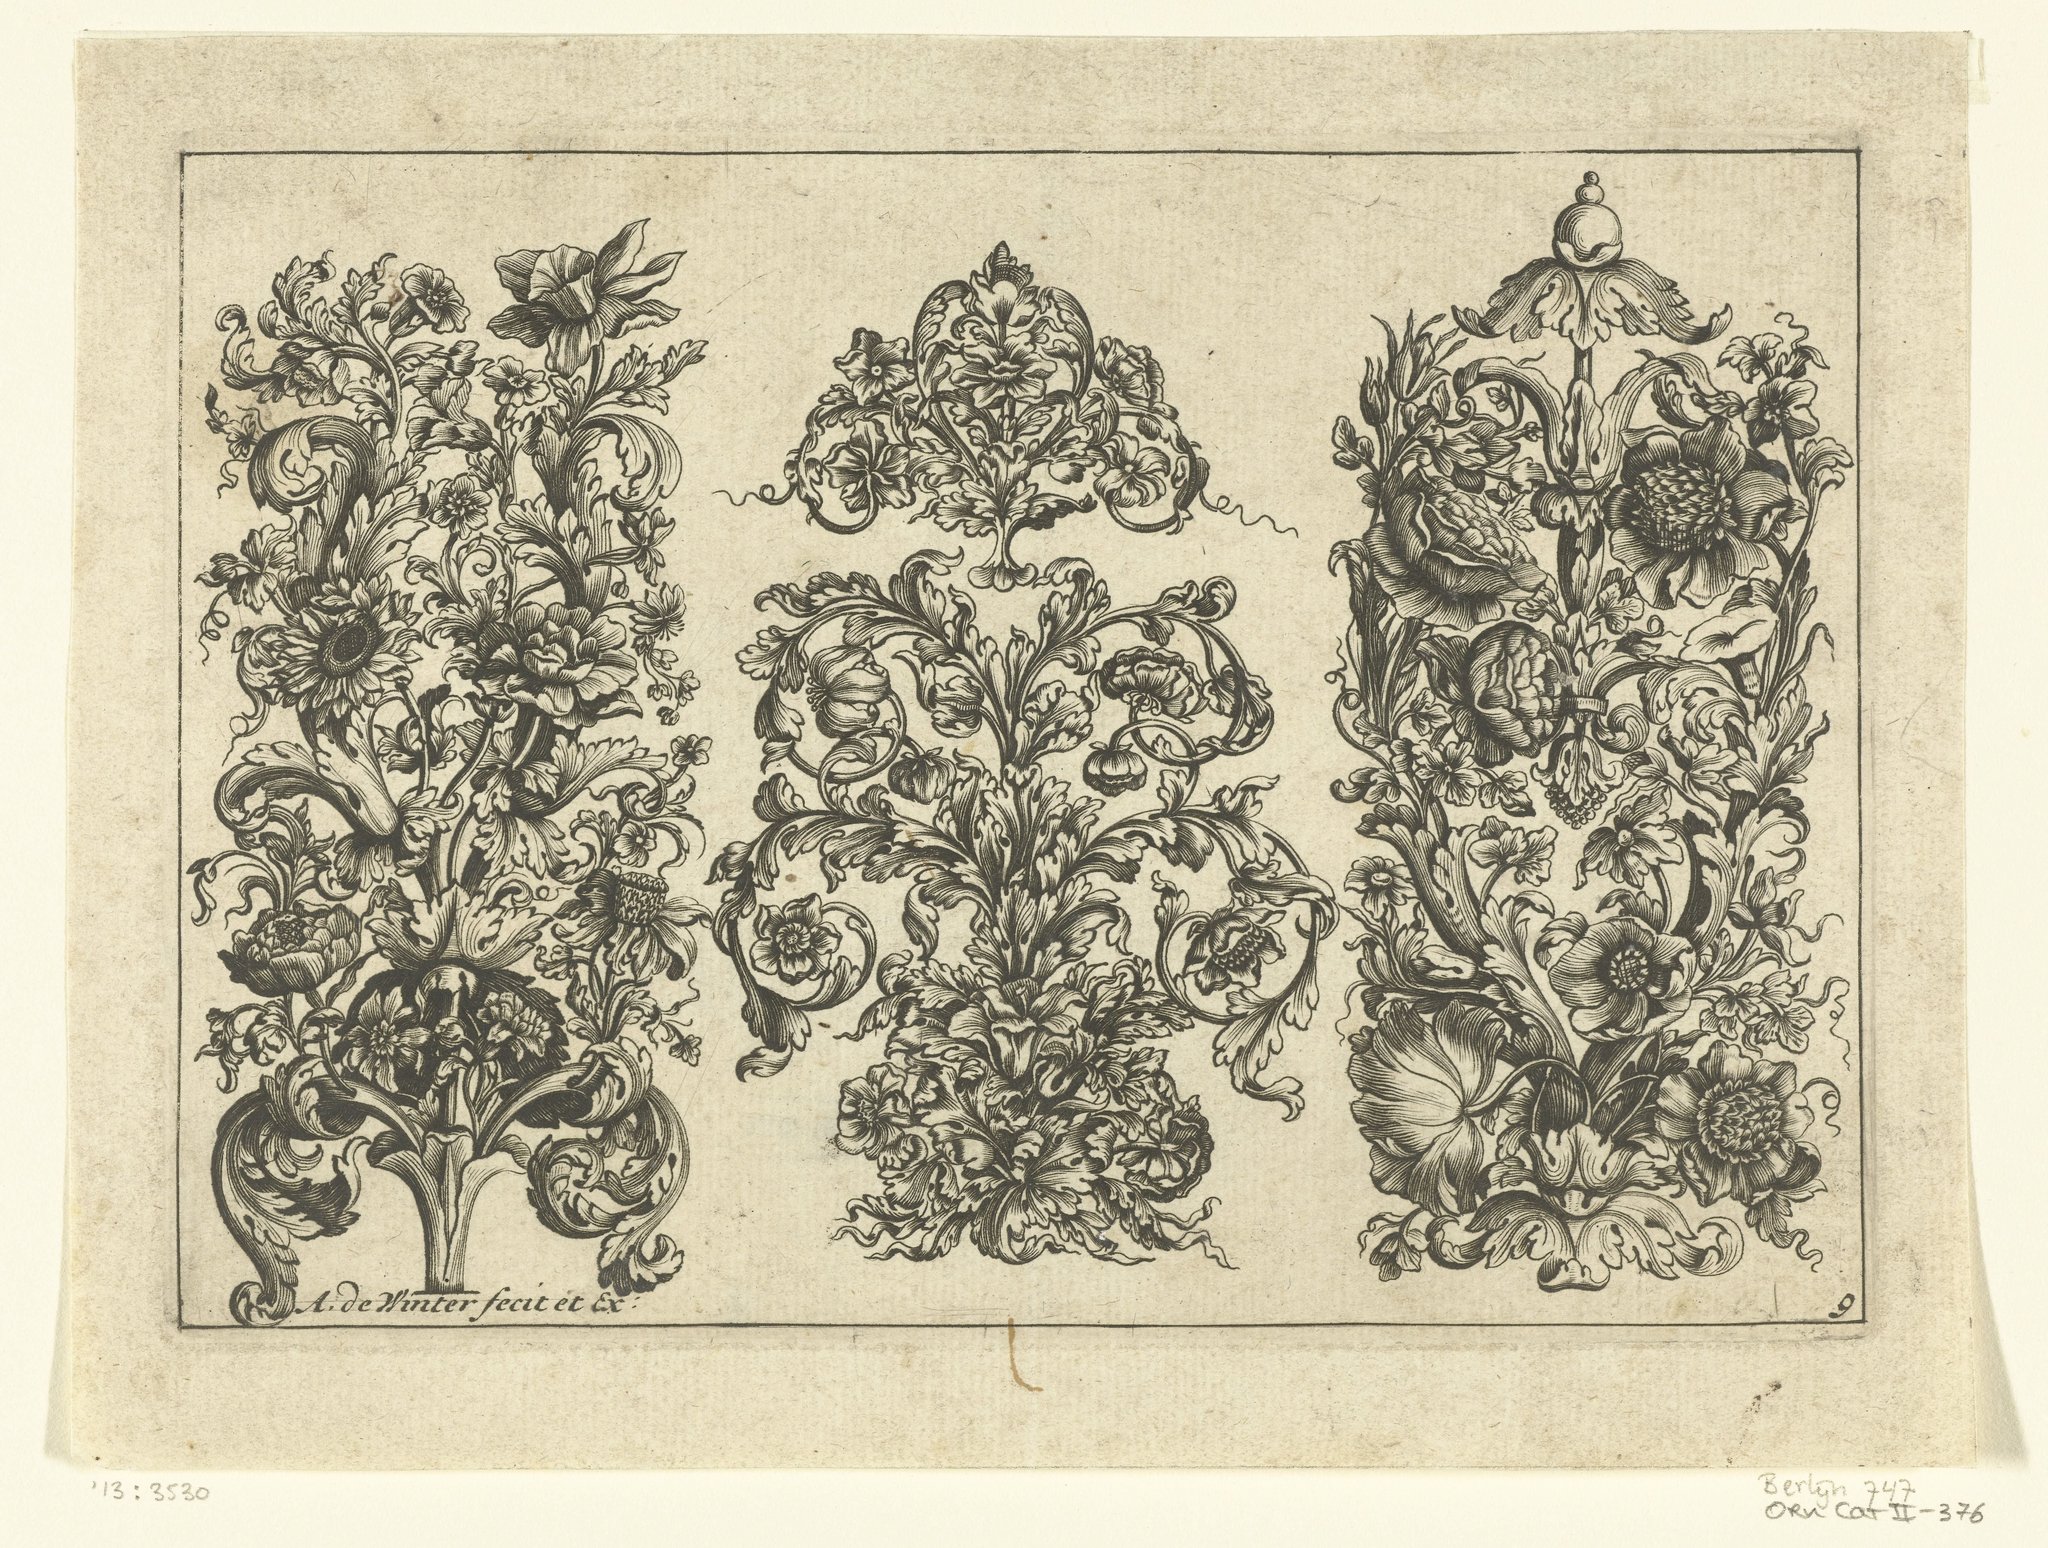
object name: print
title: Nouveau Livre d'Ornemens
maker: anthonie de winter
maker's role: print maker, publisher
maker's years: 1652-1707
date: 1690-1700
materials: paper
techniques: engraving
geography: amsterdam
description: Blad uit serie met kopieën naar Stefano della Bella, Gilles Légaré, Thomas Lejuge en anderen.